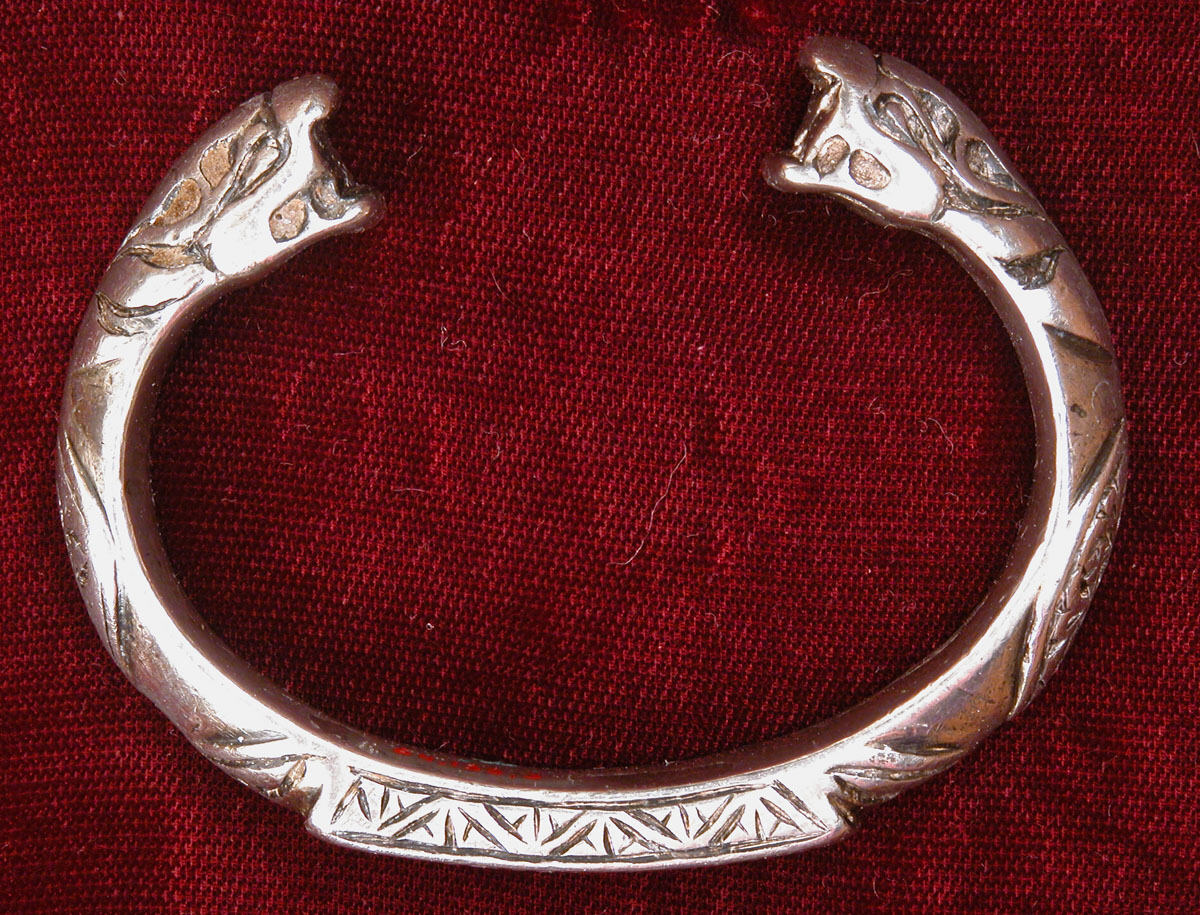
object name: bracelet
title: Bracelet with Snake-Head Endings and Arabic Inscription, One of a Pair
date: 1401-1500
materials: silver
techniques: casting, chasing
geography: central asia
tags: snakes